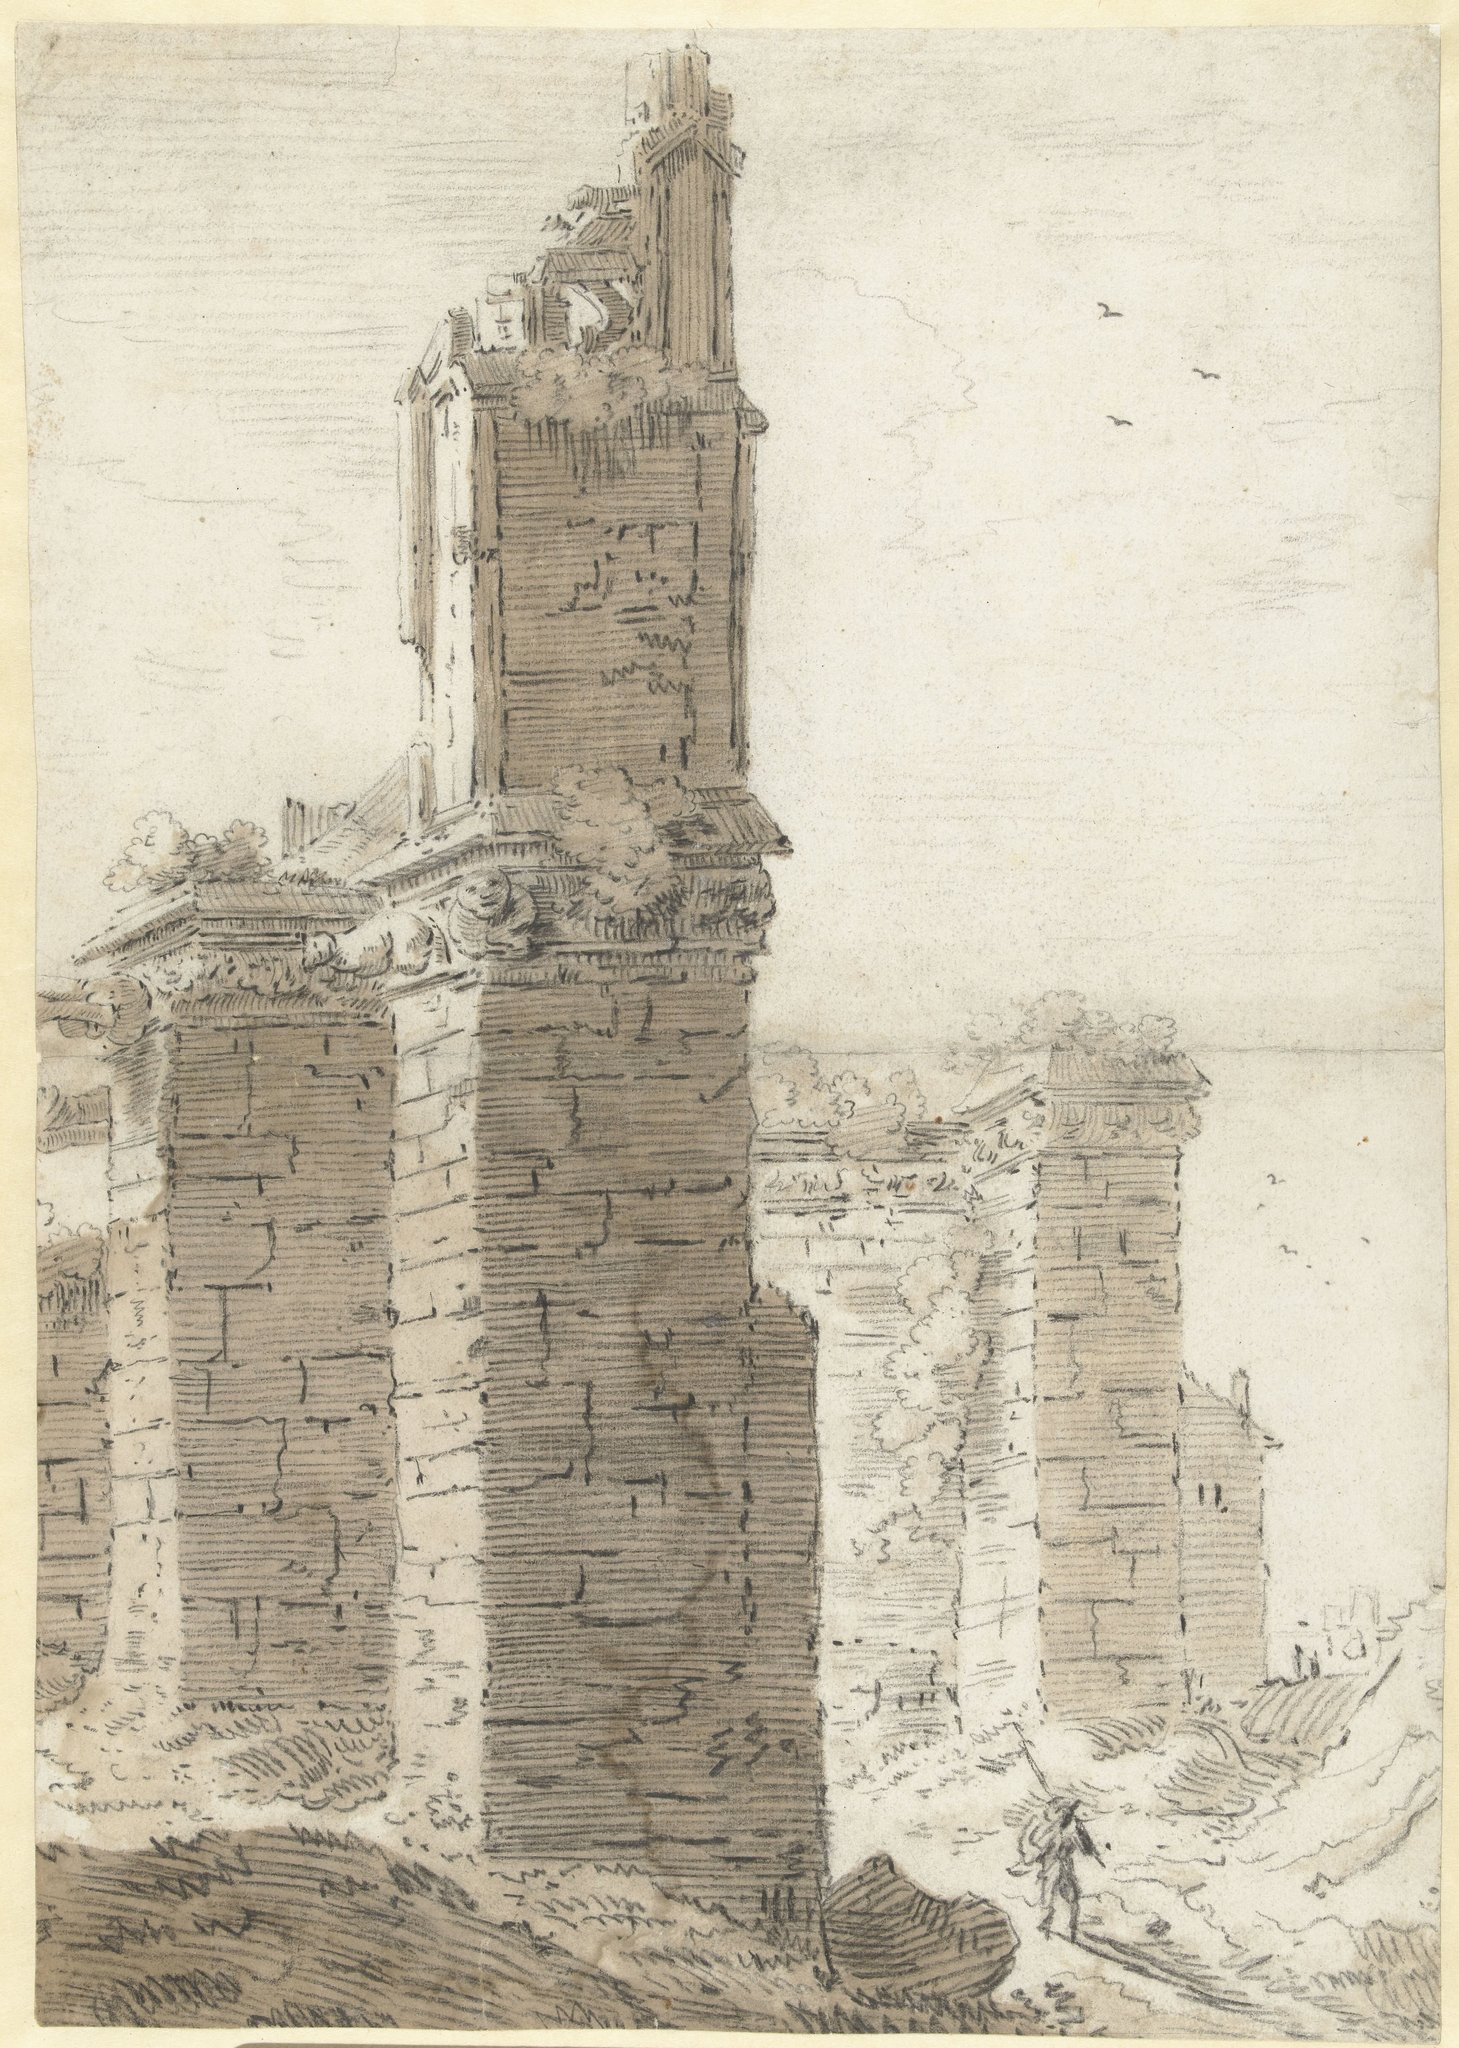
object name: drawing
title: Bouwval van een gothische kerk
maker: herman saftleven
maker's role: draughtsman, painter, print maker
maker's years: 1609-1685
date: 1619-1685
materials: chalk, paper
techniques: brush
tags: ruin of a building ~ architecture, church (exterior)